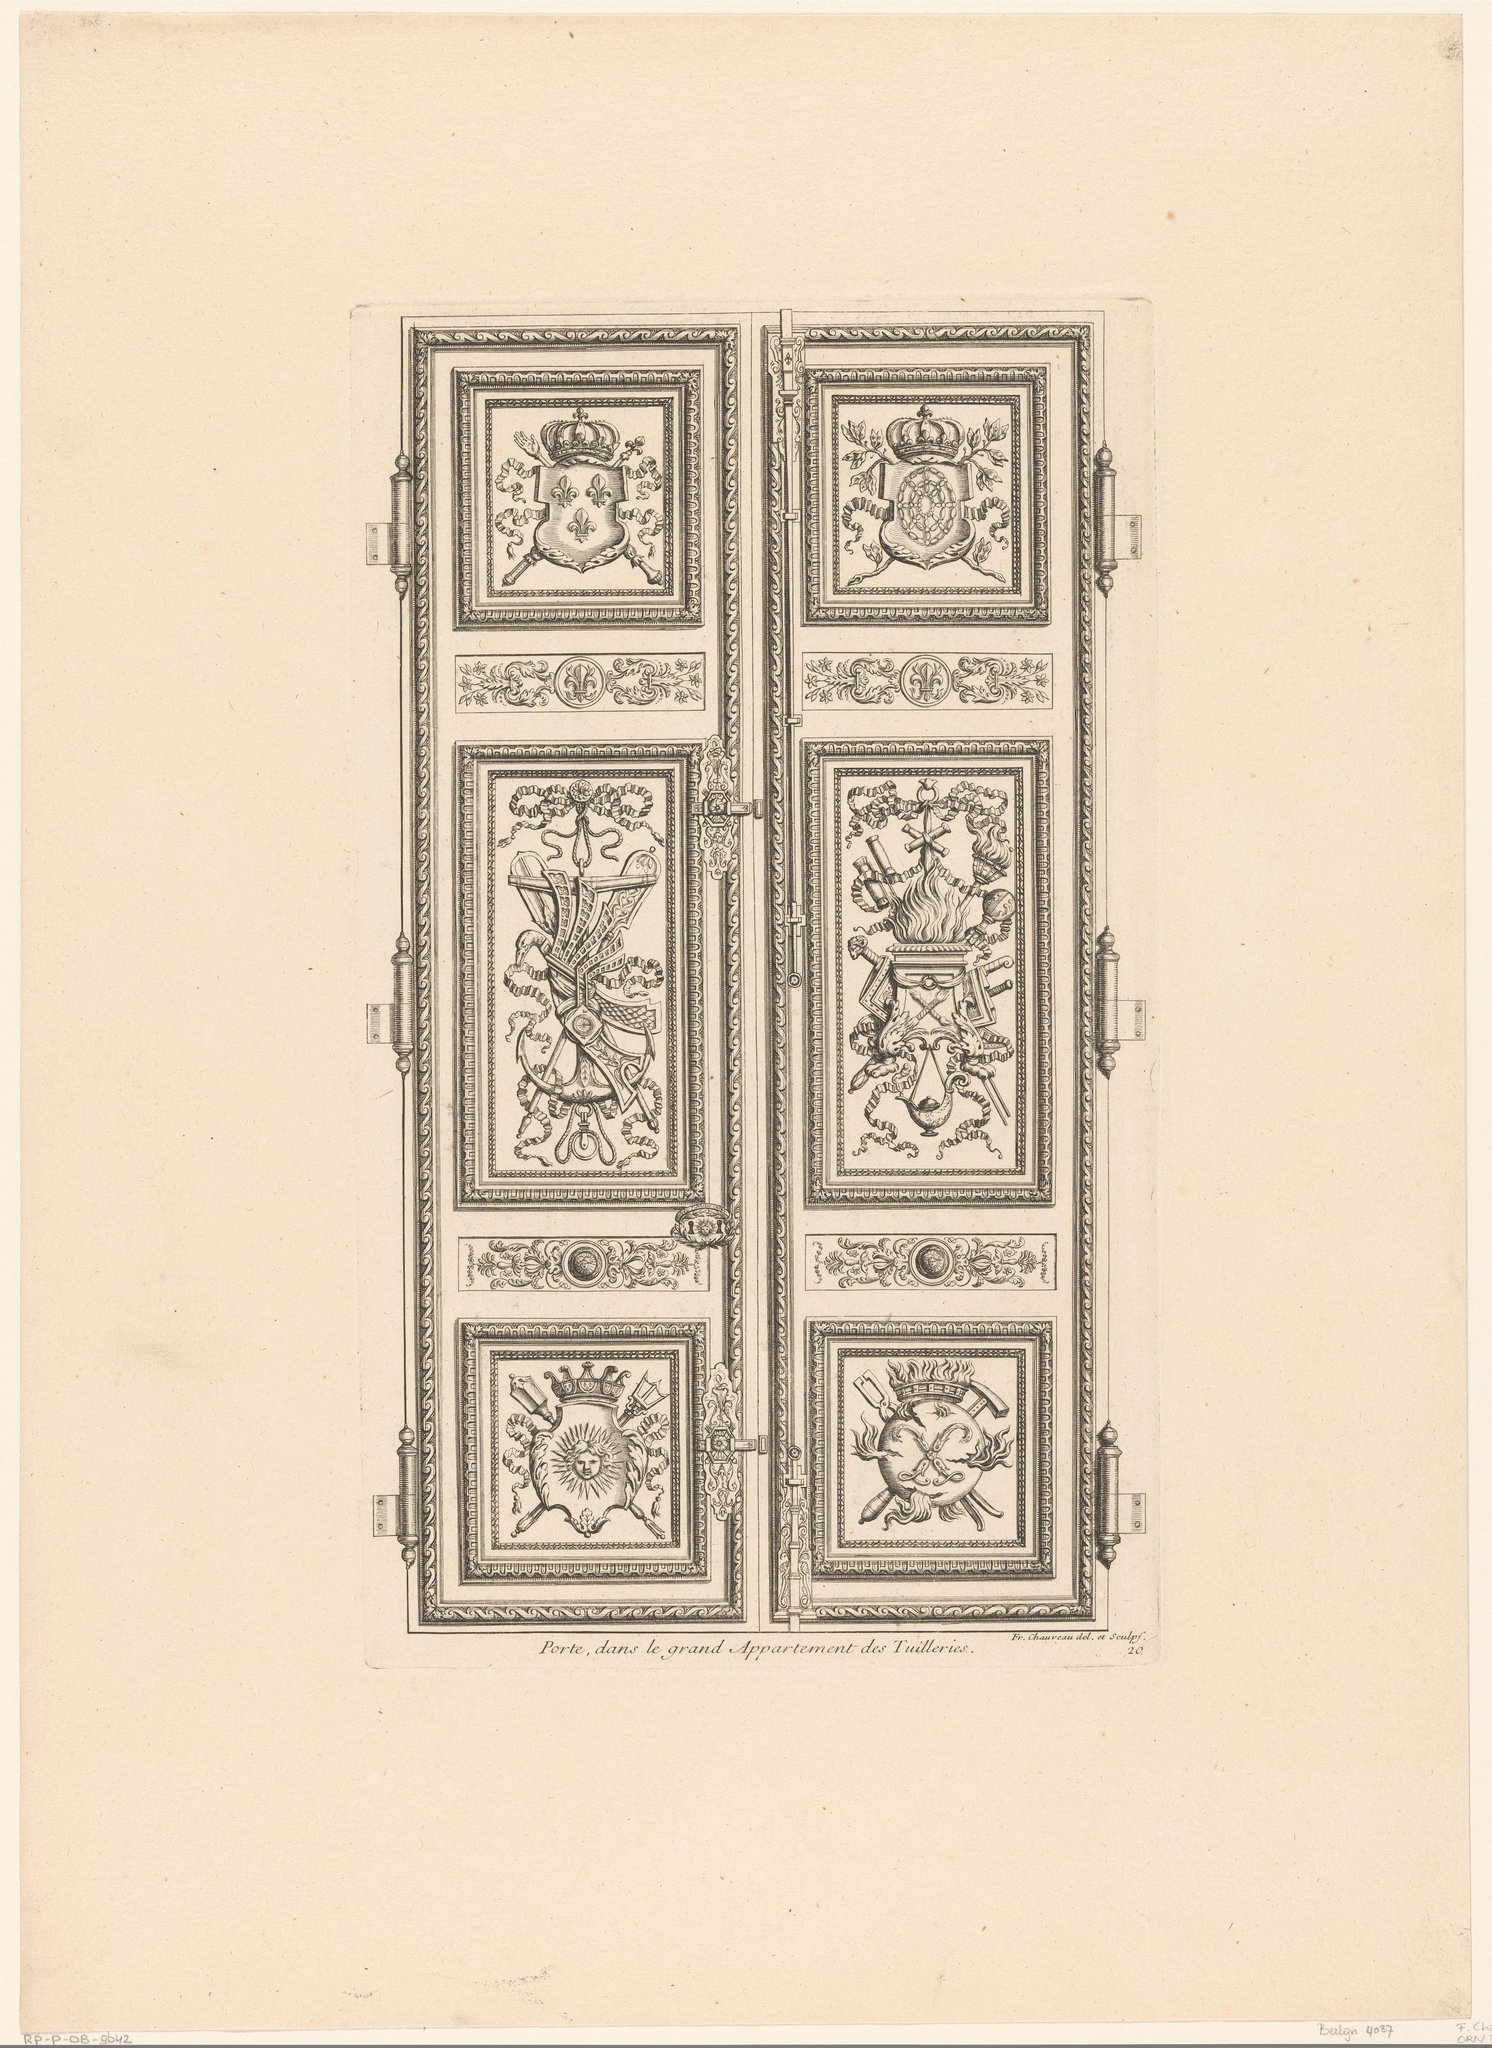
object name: ornament print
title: Deur met trofeeën en schilden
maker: françois chauveau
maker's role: draughtsman, painter, print maker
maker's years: 1613-1676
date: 1670-1676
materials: paper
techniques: etching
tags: coat of arms (symbol of sovereignty), trophy, i.e.: decorative arrangement of symbolic or typical objects ~ ornament, door, tuileries palace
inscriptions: collector's mark: Lugt 2228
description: Elf prenten van Jean Bérain le Vieux (RP-P-OB-9624 t/m 9634), dertien prenten van François Chauveau (RP-P-OB-9635 t/m 9647), vier prenten van Lemoine (RP-P-OB-9674 t/m 9677) en een titelprent (in 1710 toegevoegd) vormen tezamen een serie van 29.